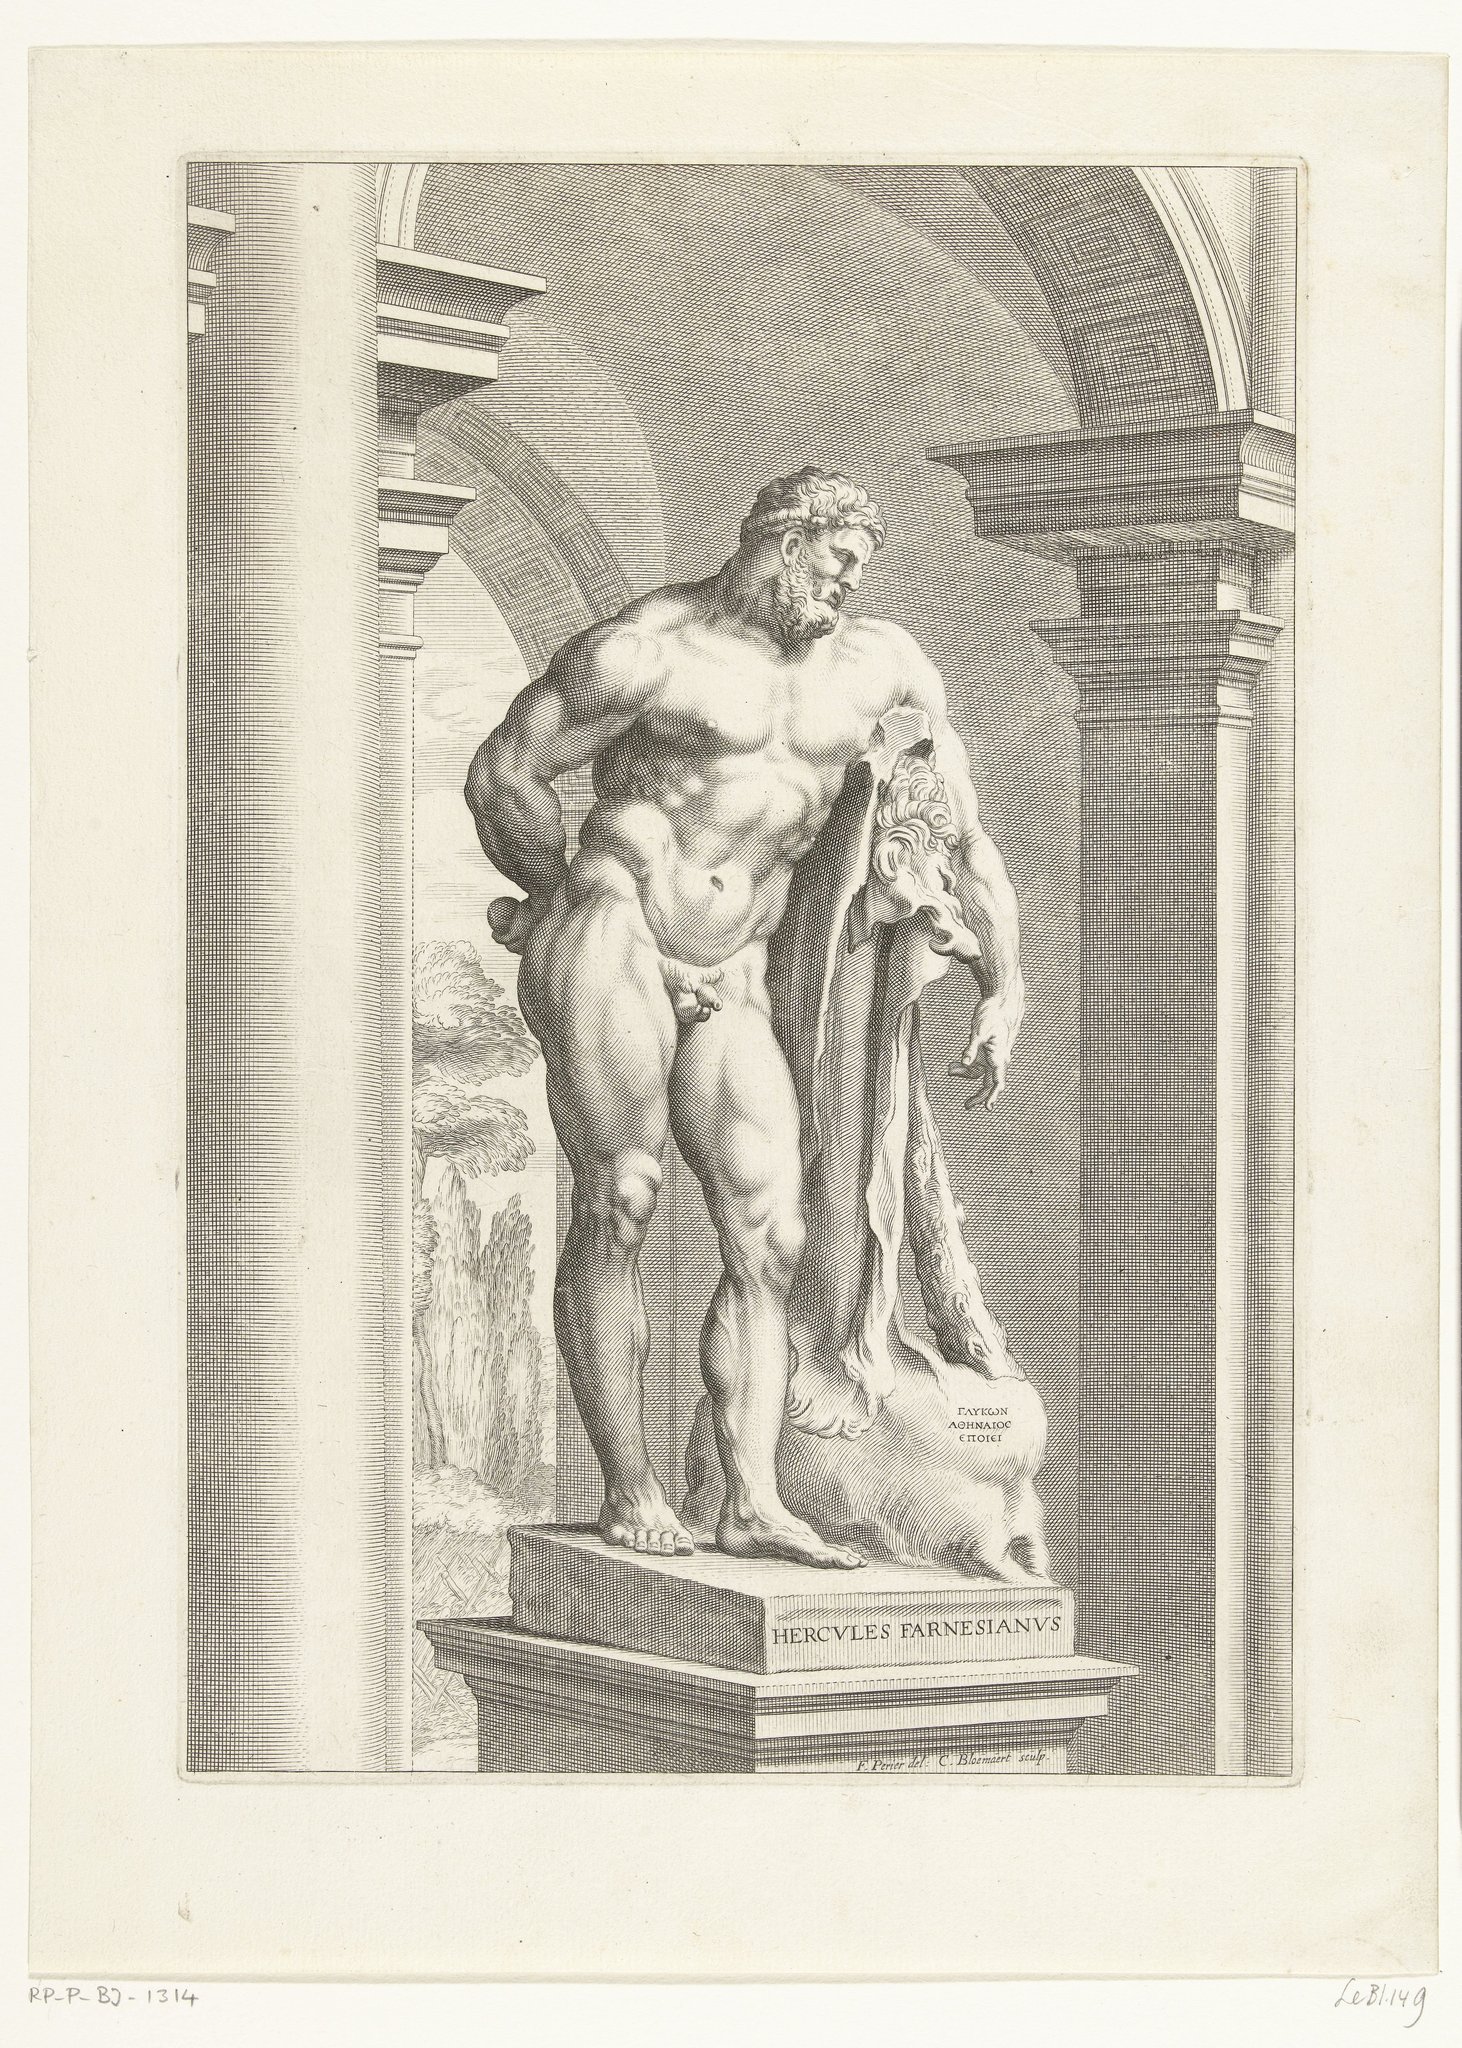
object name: print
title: Hercules Farnese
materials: paper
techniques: engraving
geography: rome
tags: piece of sculpture, reproduction of a piece of sculpture, specific aspects, allegorical aspects of hercules; hercules as patron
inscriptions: collector's mark: Lugt 240, collector's mark: Lugt 2228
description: Een groot beeld van Hercules, leunend op zijn knots. Tot 1787 stond dit beeld in het Palazzo Farnese, vandaar de benaming Hercules Farnese. Het beeld is in een nis geplaatst.